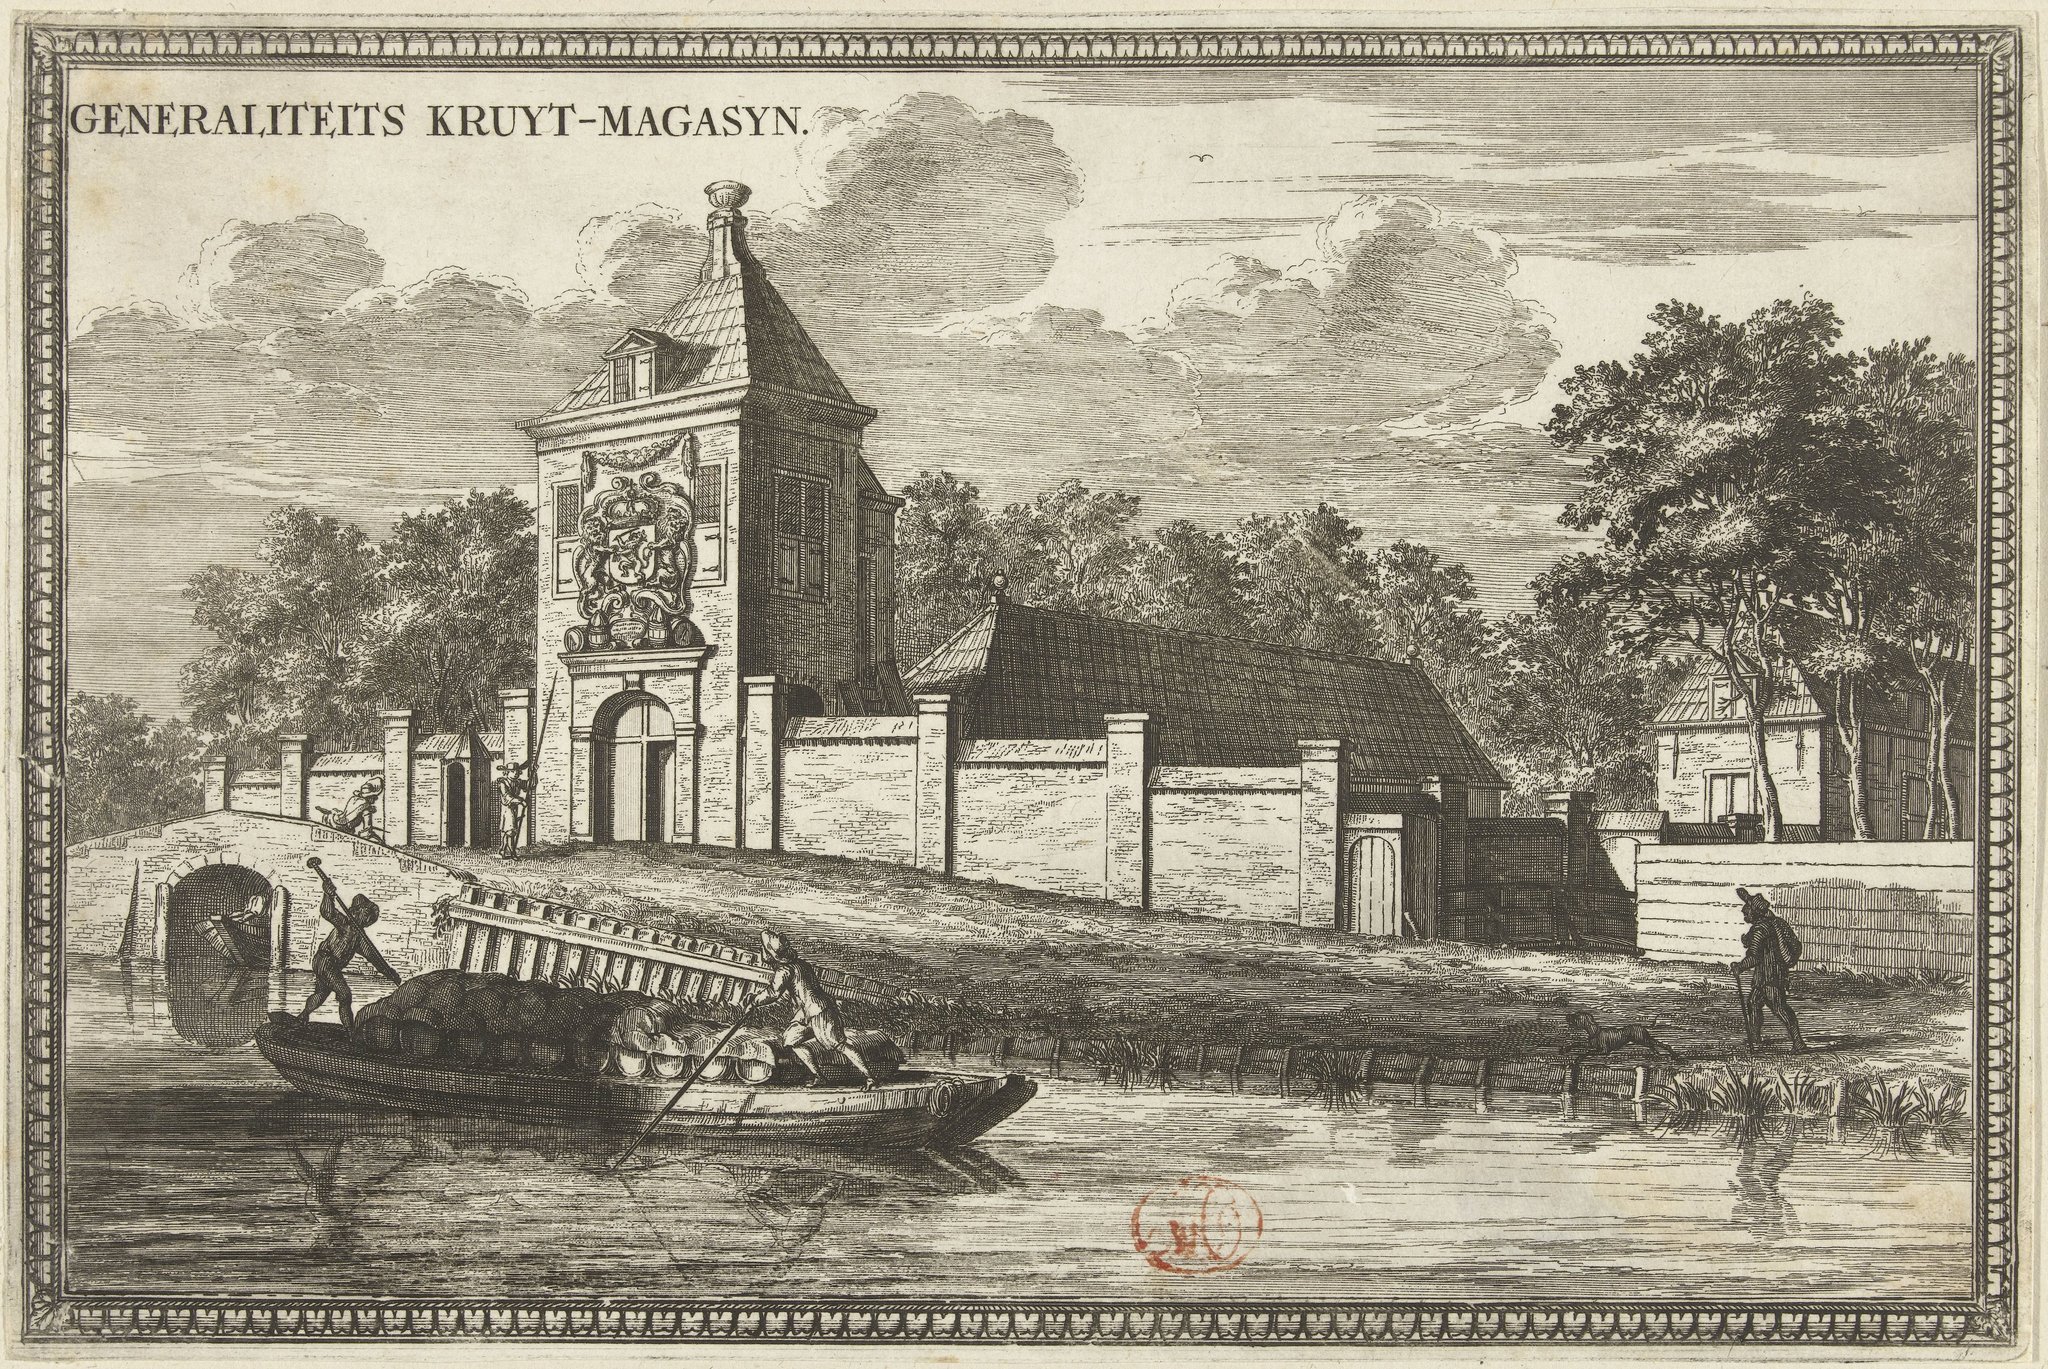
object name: print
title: Generaliteits Kruyt-magasyn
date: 1678-1703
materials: paper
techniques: etching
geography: amsterdam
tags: ammunition store, arsenal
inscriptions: collector's mark: Lugt 195, collector's mark: Lugt 2228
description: Deze prent is in 1678 voor het eerst uitgegeven als onderdeel van de rand van de zogenaamde Kaart Figuratief (Caerte figuratyff / Kaerte figuratyf) van Delft, een wandkaart van Delft. Deze kaart bestaat uit een plattegrond van Delft (RP-P-AO-11-8A) met daaromheen een rand. De rand bestaat uit een profiel van Delft (RP-P-AO-11-11), een profiel van Delfshaven met daaronder de wapenschilden van de burgemeesters van de stad (RP-P-AO-13-51-1 en RP-P-AO-13-51-2), 24 kleinere prenten (kaarten, afbeeldingen van gebouwen en graven van bekende personen, o.a. huidige prent, RP-P-AO-11-15, RP-P-AO-11-17, RP-P-AO-11-18, RP-P-AO-11-19, RP-P-AO-11-20, RP-P-AO-11-21, RP-P-AO-11-23, RP-P-AO-11-24, RP-P-AO-11-27, RP-P-AO-11-28, RP-P-AO-11-29, RP-P-AO-11-30, RP-P-AO-11-31, RP-P-AO-11-33C, RP-P-AO-11-34, RP-P-AO-11-35, RP-P-AO-11-35-2, RP-P-AO-13-49, RP-P-AO-13-52, RP-P-AO-13-53, RP-P-AO-13-54-1 en RP-P-1909-6463) en een beschrijving van de stad (RP-P-AO-11-8E). De eerste druk van deze Kaart Figuratief (1678) werd, in opdracht van het Delftse stadsbestuur, verzorgd door Pieter Smith. In 1680 leverde Smith ook vijfhonderd afdrukken van de randprenten die bestemd waren voor Dirk Evertsz. Bleyswijcks 'Beschryvinge der stadt Delft' (1667) en het tweede deel: 'Vervolg van de beschryvinge der stadt Delft' (1680). In het tweede deel zat een bijlage waarin beschreven staat welke prenten waar in het eerste en tweede deel ingebonden dienden te worden. Een deel van de prenten was dus bestemd voor het in 1667 verschenen eerste deel en kon met het verschijnen van het tweede deel in 1680 alsnog worden ingebonden. Hierdoor wordt vaak gedacht dat de prenten uit het eerste deel dateren uit 1667, hetgeen niet klopt. De huidige prent is zodoende ook gebruikt in: Bleyswijck, Dirk Evertsz. Vervolg van de beschryvinge der stadt Delft, met een generael register over beyde stucken voorsien. Delft: Arnold Bon, 1680, p. 636. Pieter Mortier (I) verzorgde in 1703, tevens in opdracht van het stadsbestuur, een tweede uitgave van de Kaart Figuratief. Voor deze druk bracht graveur Thomas van der Wilt enkele aanpassingen aan op de platen van de plattegrond. De randplaten lijken, op de plaat met de wapens van de burgemeesters na, ongewijzigd te zijn gebleven. De plattegrond is in 1752, waarschijnlijk zonder de randprenten, opnieuw uitgegeven. Een deel van de randprenten, waaronder de huidige prent, is in 1729 opnieuw gebruikt in: Beschryving der stadt Delft, behelzende een zeer naaukeurige en uitvoerige verhandeling van deszelfs eerste oorsprong (…). Delft: Reinier Boitet, 1729. Op twee na (die van de Nieuwe en Oude Kerk) paste Boitet de platen aan, waardoor van deze prenten een tweede staat ontstond. Of de huidige prent is gebruikt als onderdeel van de rand van de Kaart Figuratief uit 1678 of 1703, of is gebruikt in 'Vervolg van de beschryvinge der stadt Delft' (1680), is niet na te gaan.